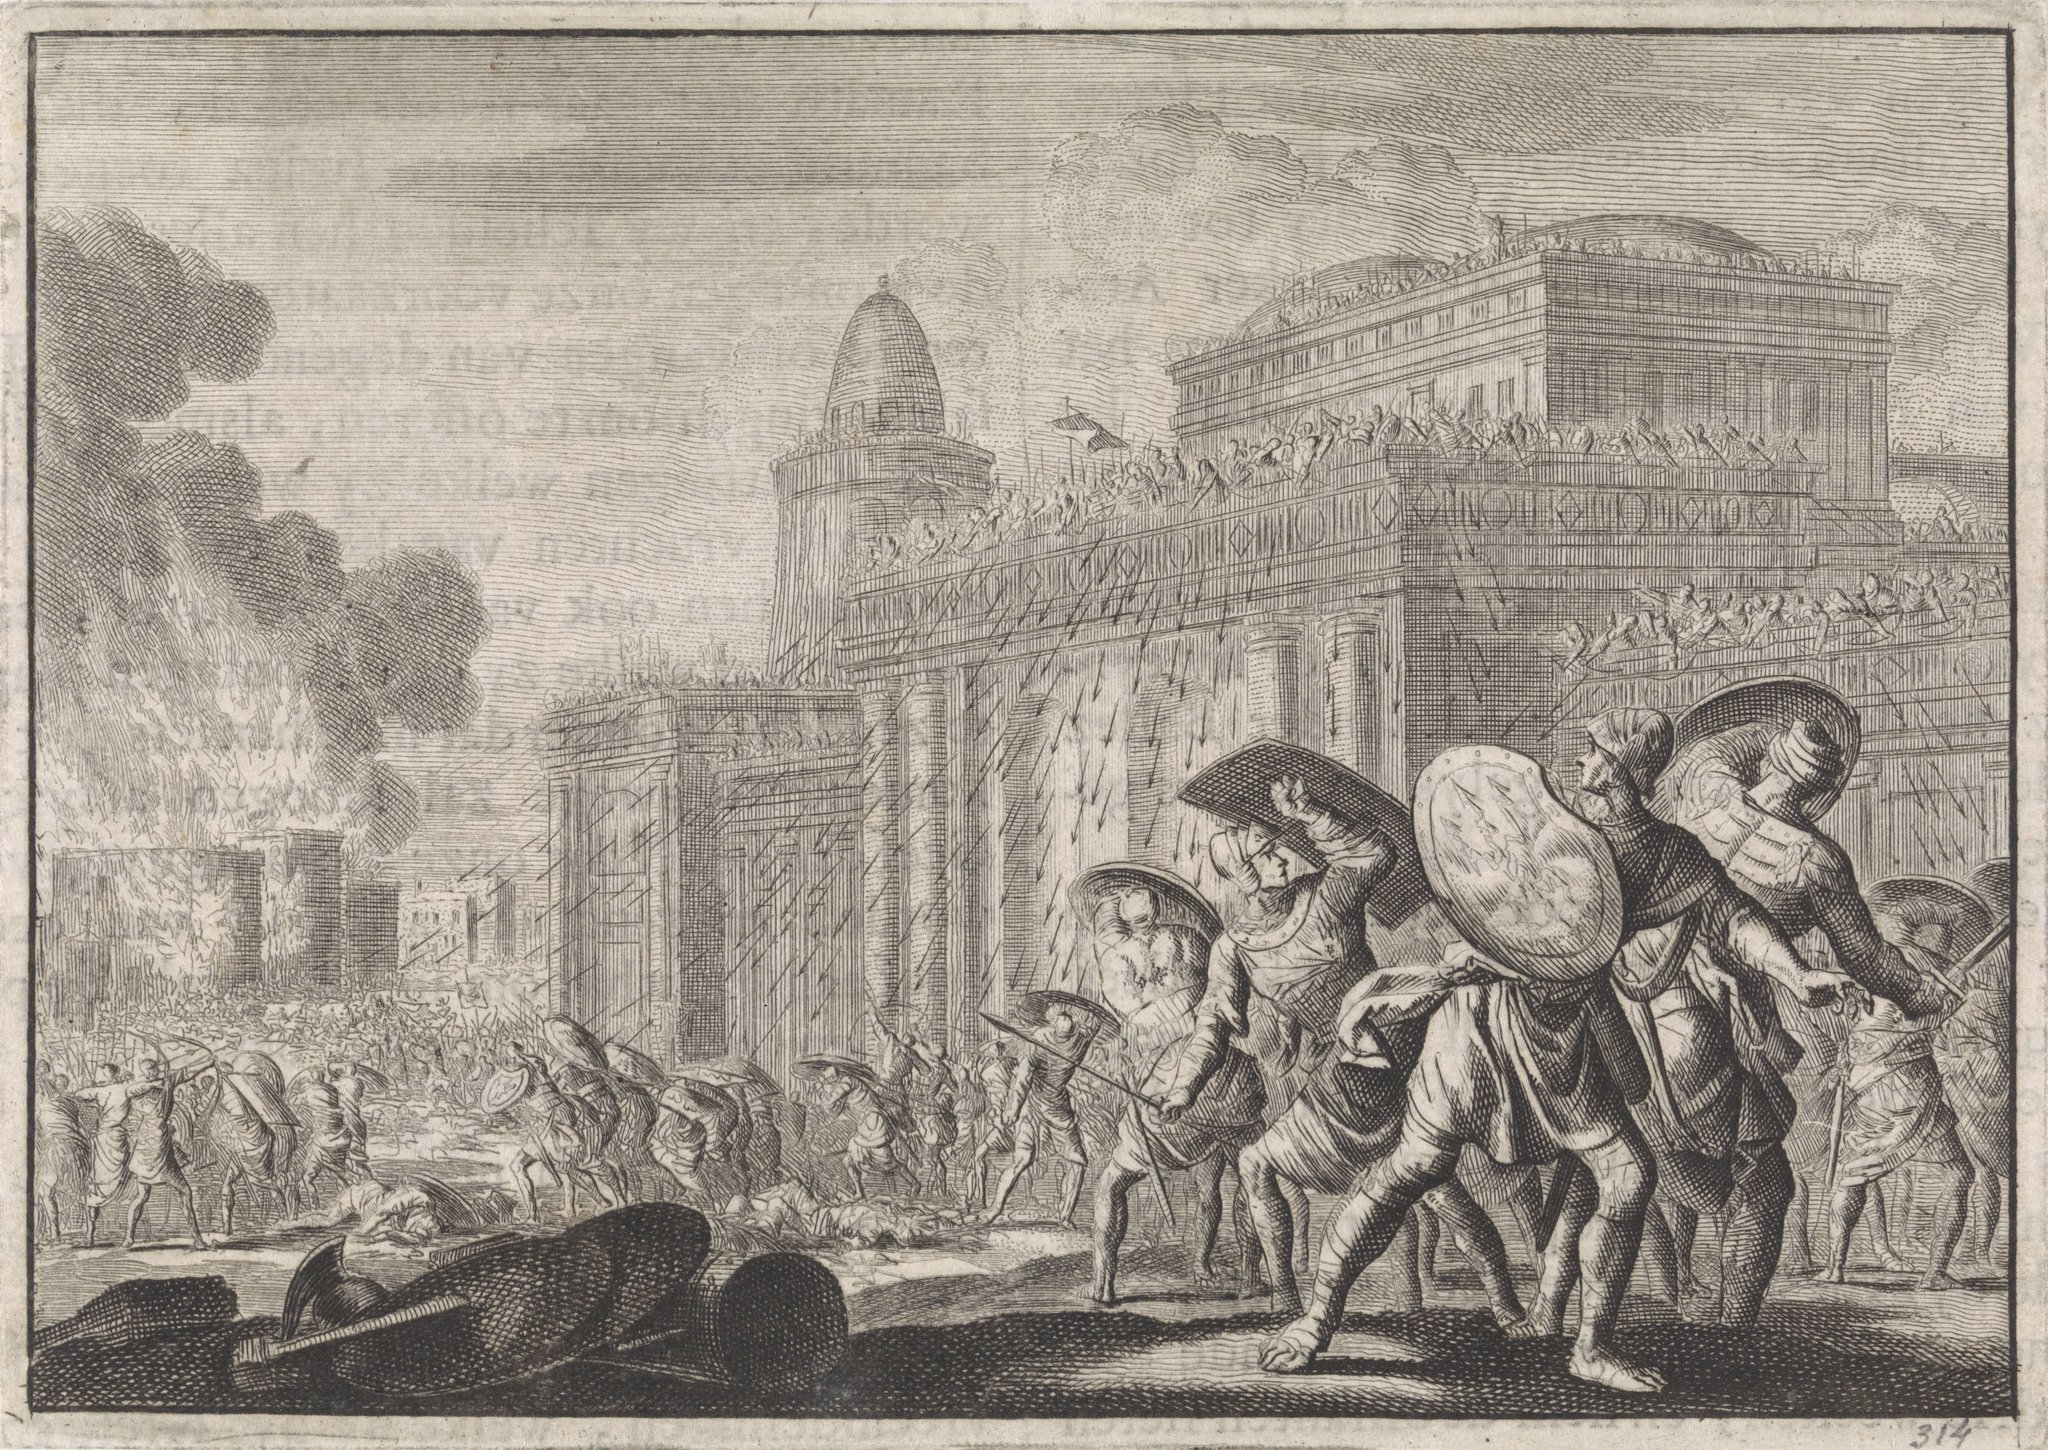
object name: book illustration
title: Paleis van koning Demetrius Nikanor in Antiochië door de bevolking aangevallen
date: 1704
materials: paper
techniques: etching, letterpress printing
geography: amsterdam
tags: jonathan's army resumes the attack and defeats the army of demetrius ii nikator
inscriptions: collector's mark: Lugt 2228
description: Prent opgenomen in: Josephus, Flavius. Alle de Werken, 2 delen. Amsterdam: Pieter Mortier, 1704, dl. 1, p. 314.